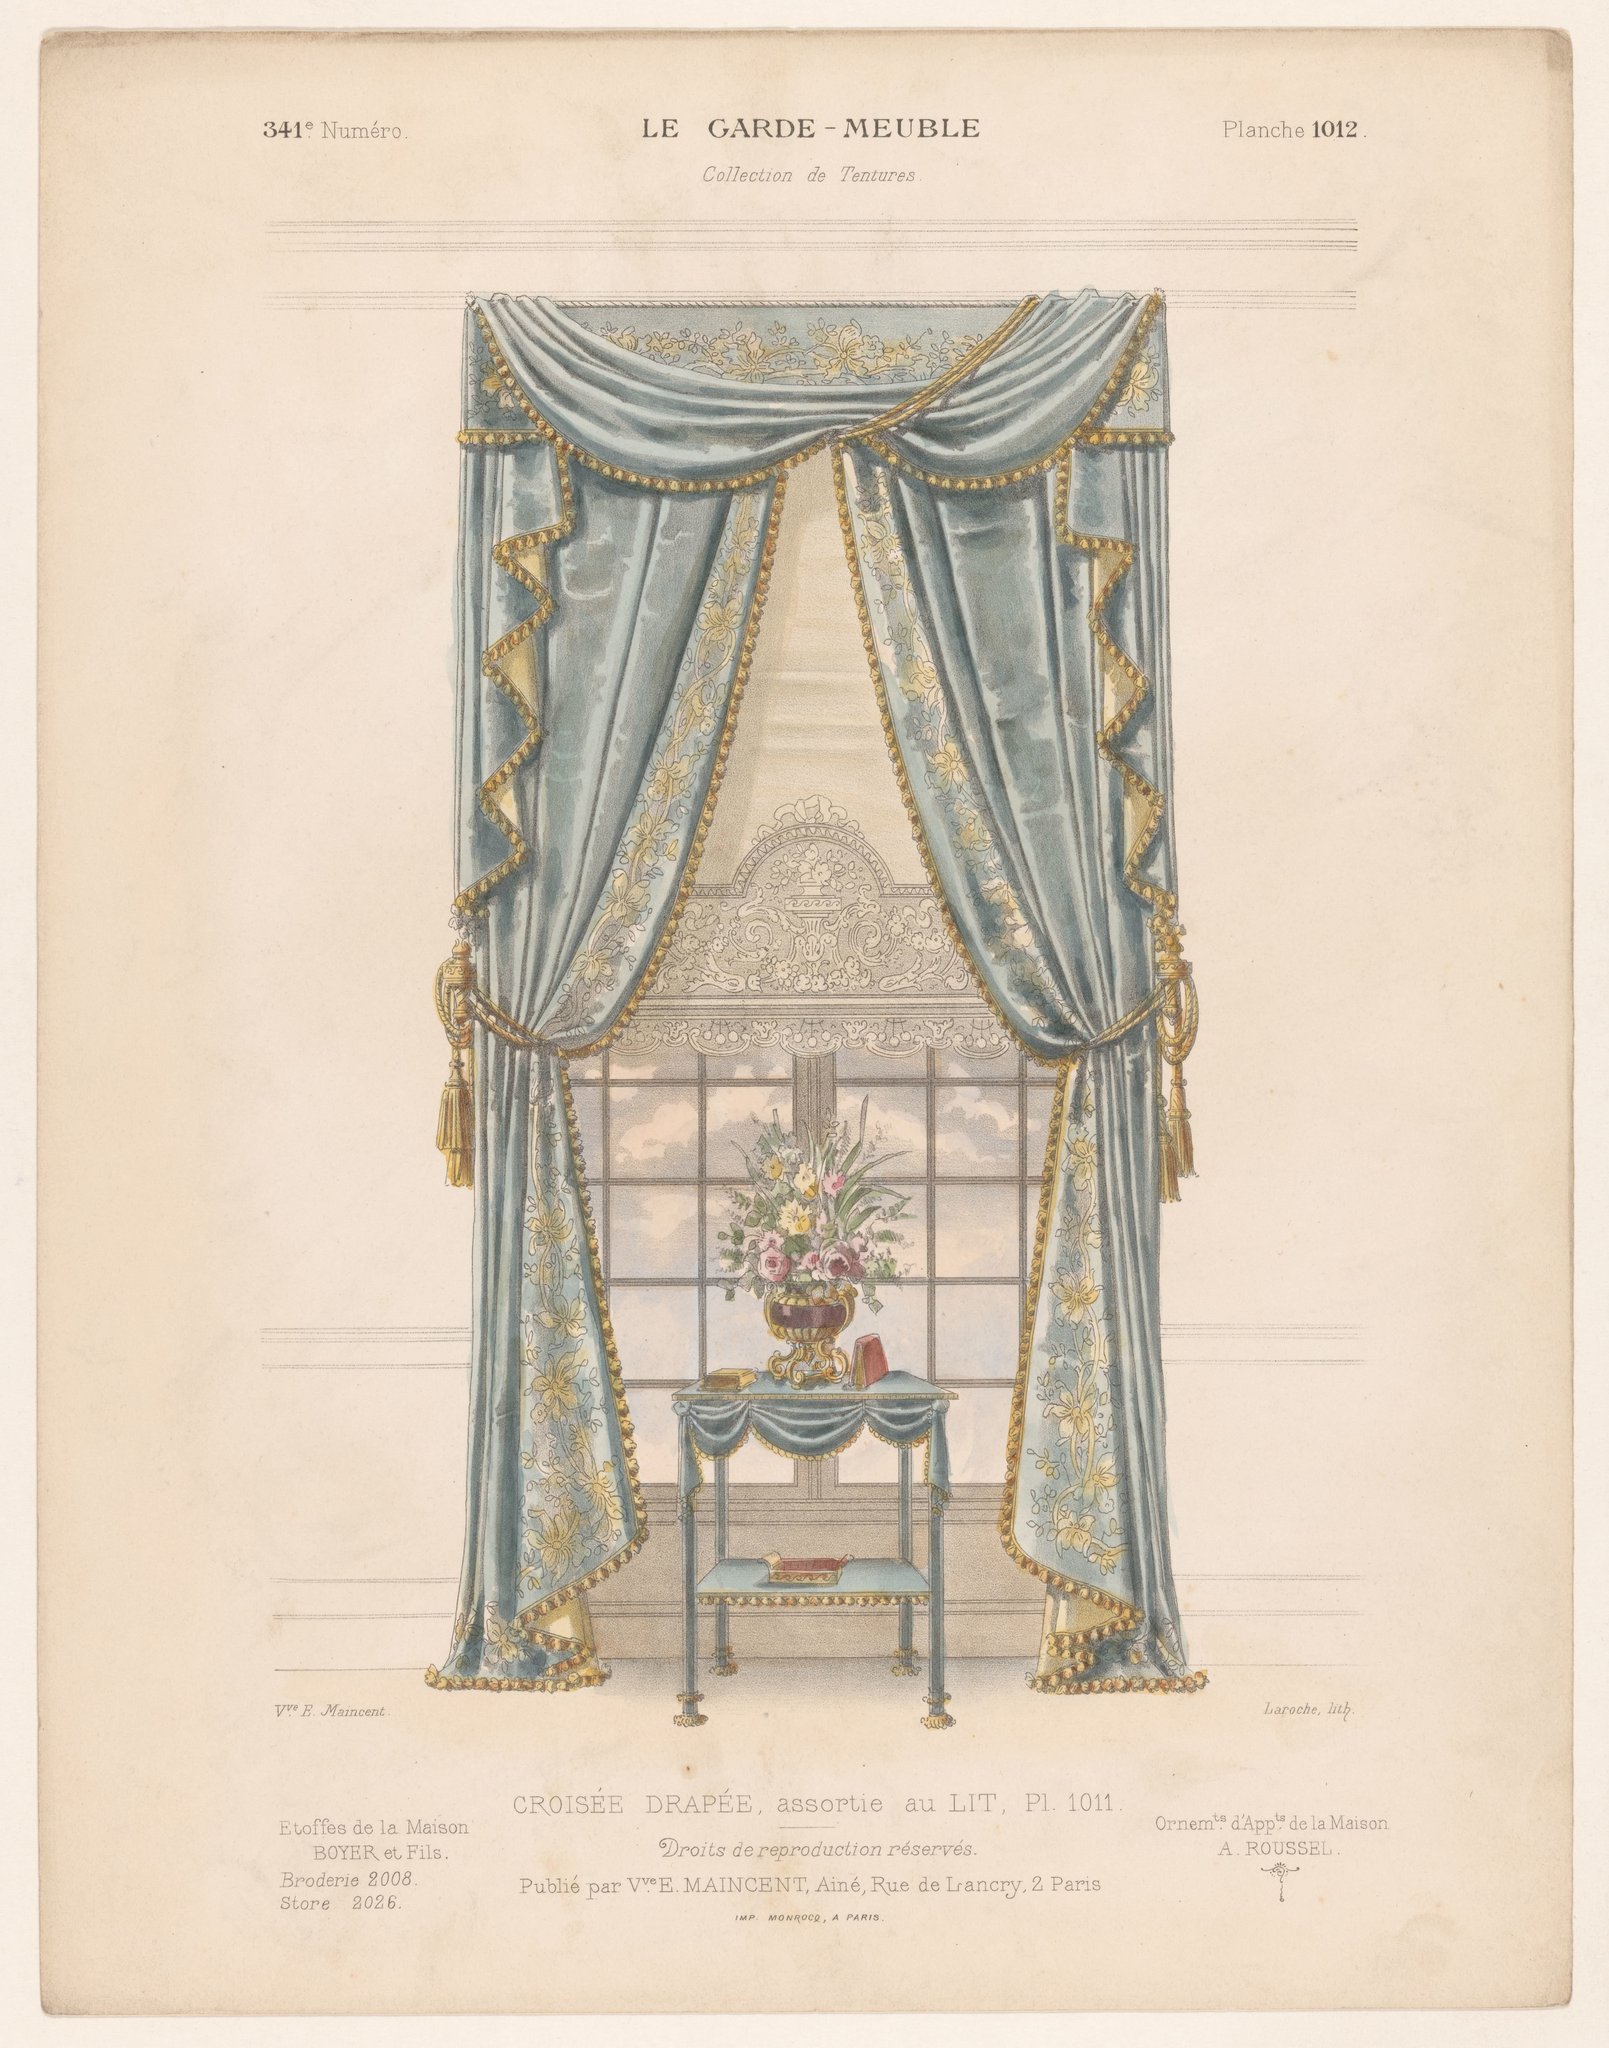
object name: print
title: Venster met gordijnen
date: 1895-1910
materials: paper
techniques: hand coloring, lithograph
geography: paris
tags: window, hangings and drapery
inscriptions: : ‘Droits de reproduction réservés.’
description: Kruisvenster met gedrapeerde gordijnen, passend bij het bed van serienr. 1011. Prent uit 341e Livraison.